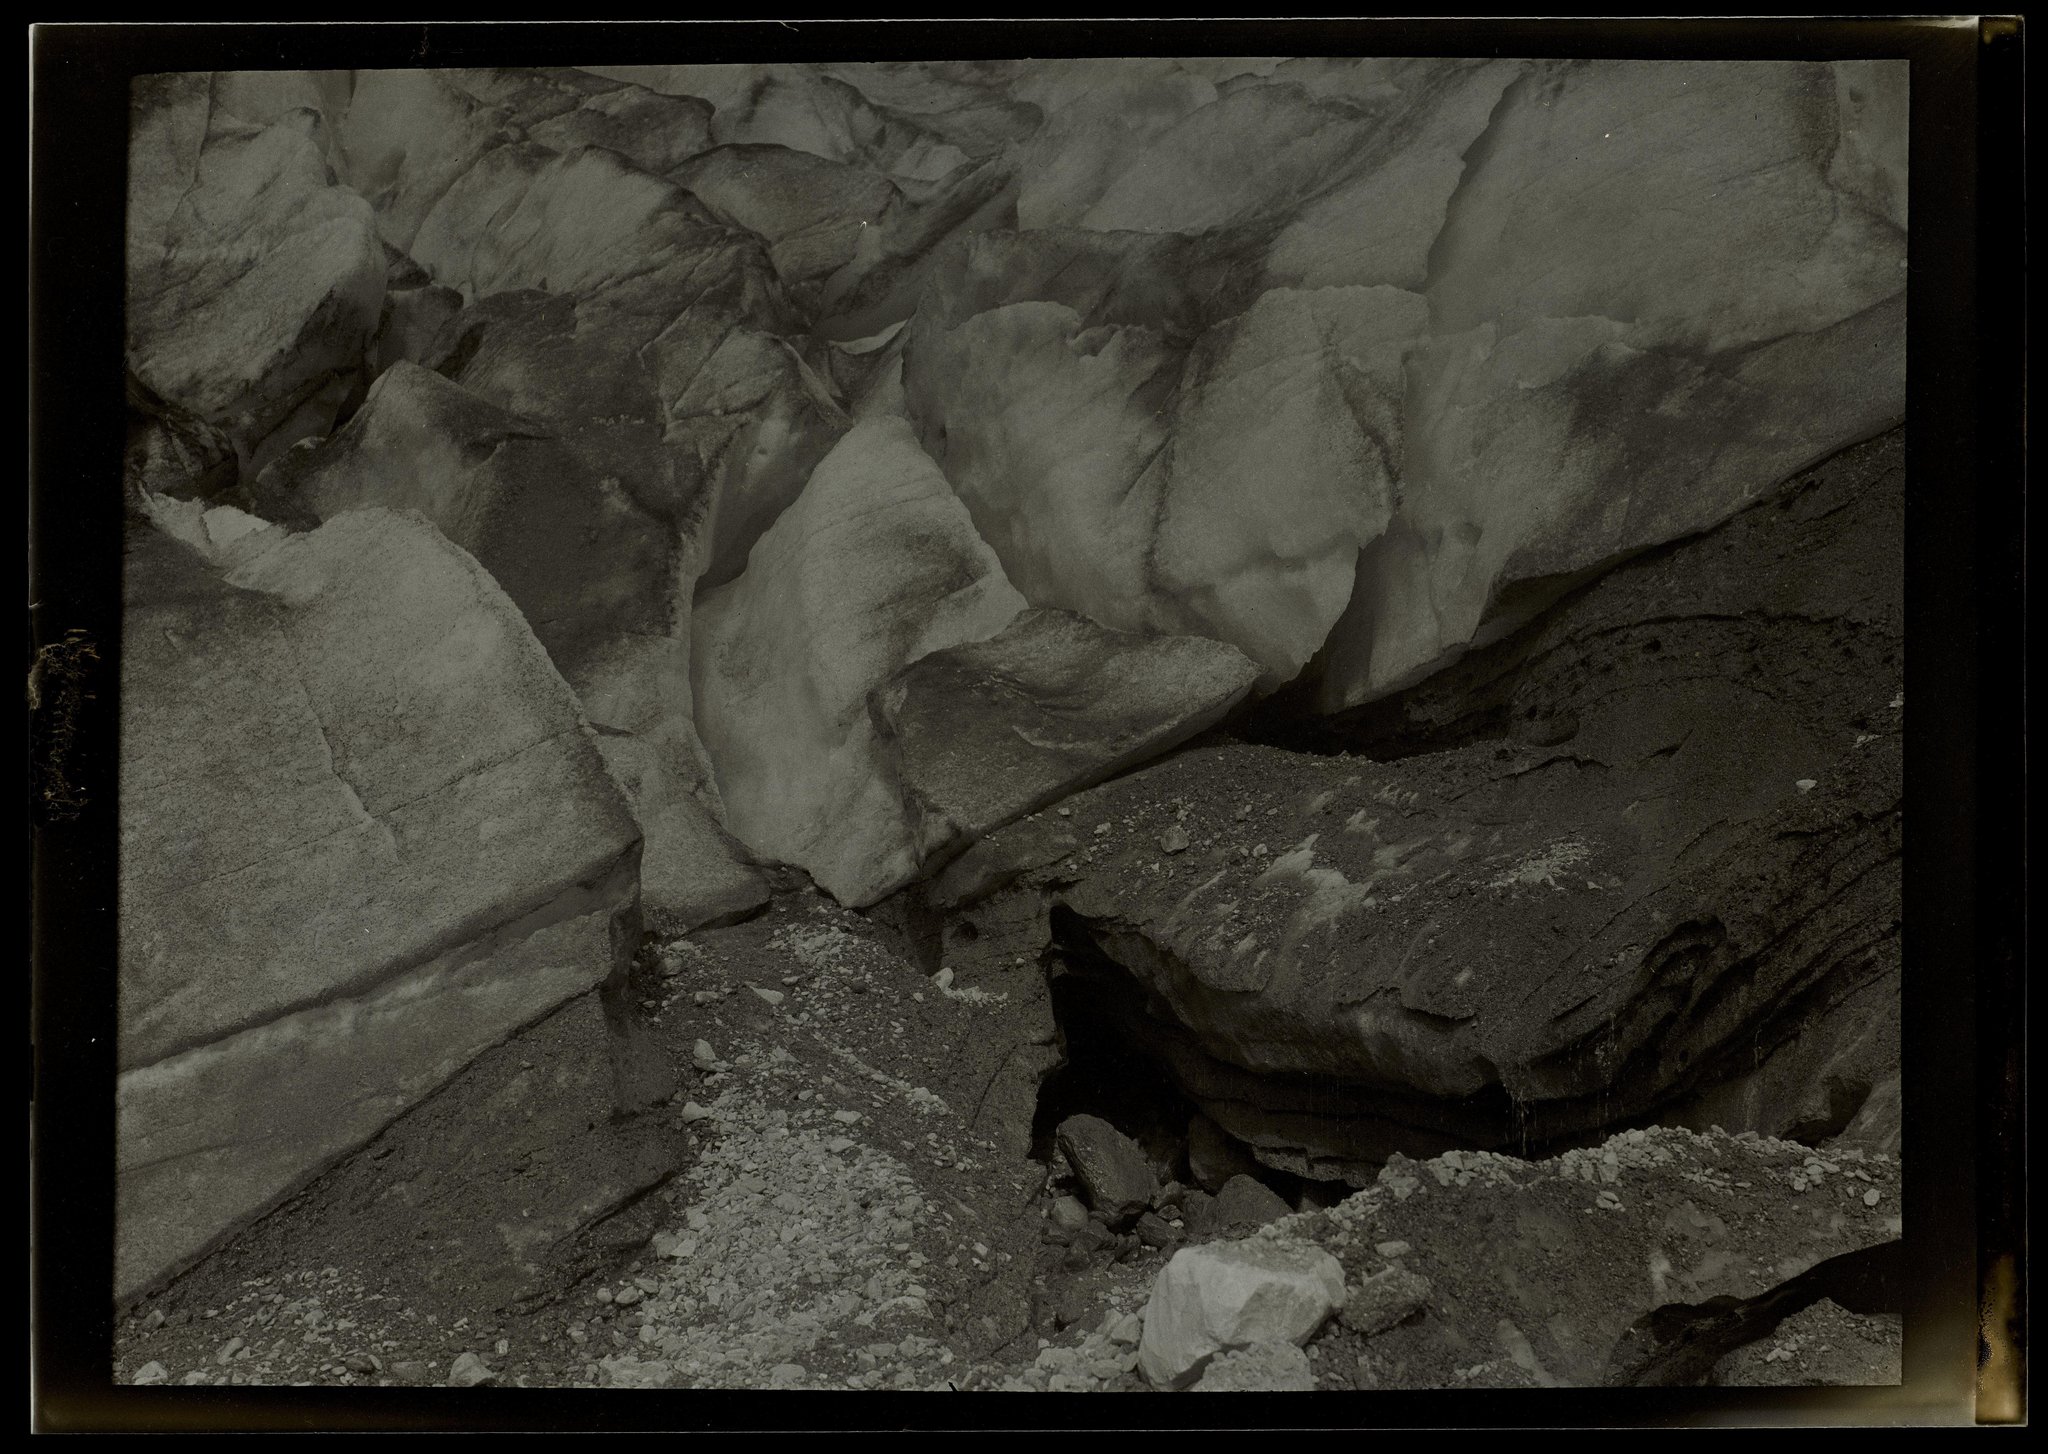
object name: photograph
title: Filmnegatief met opname van Zermatt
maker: Anonymous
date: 1921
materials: film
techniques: gelatin silver negative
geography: zermatt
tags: zermatt